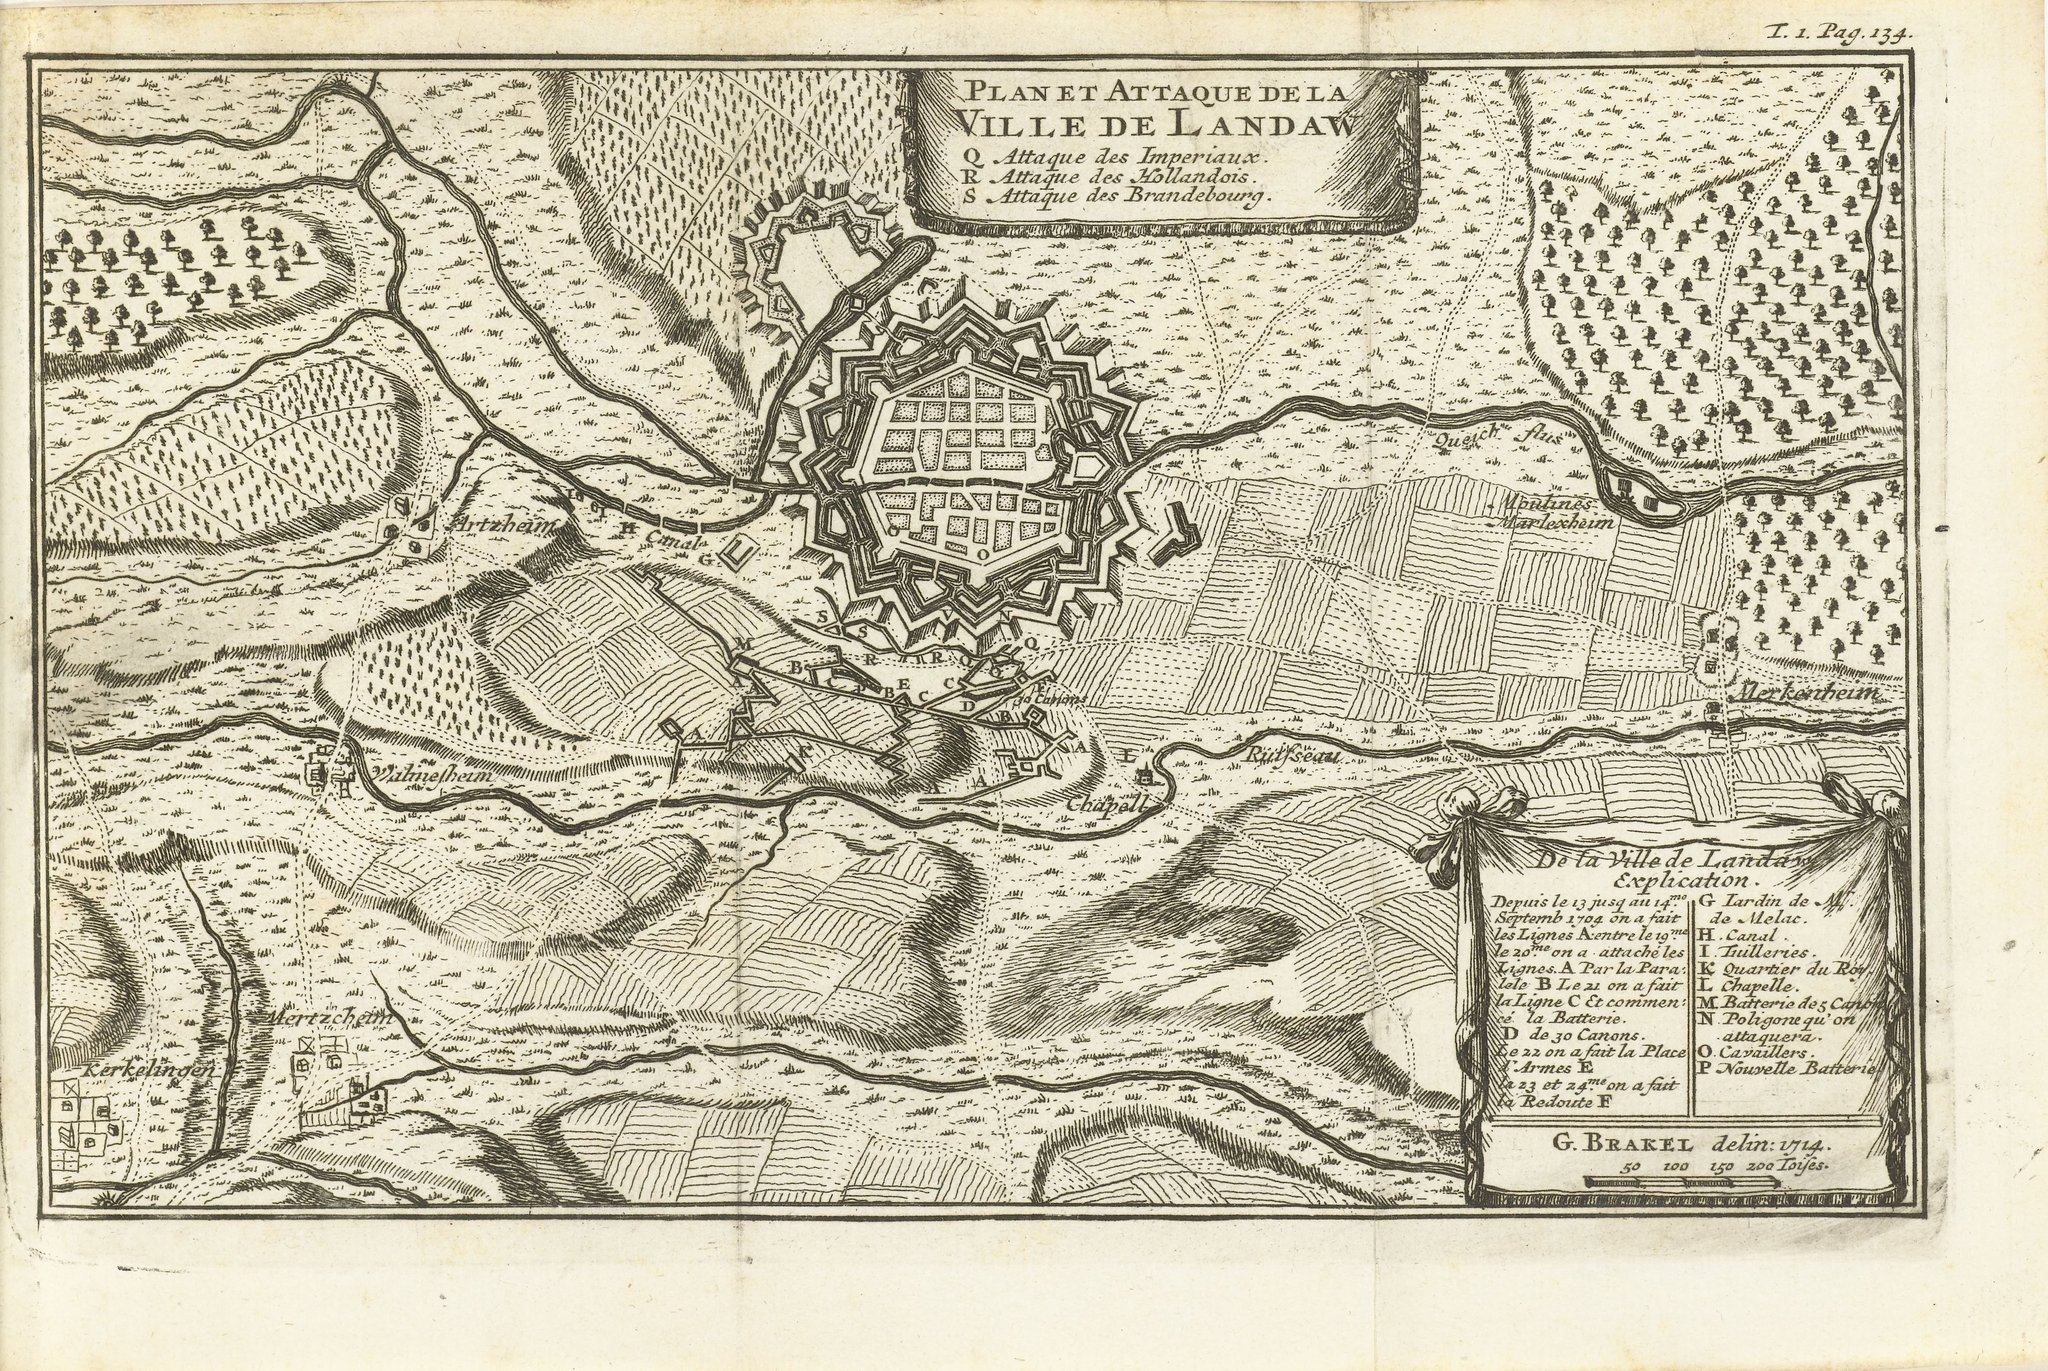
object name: map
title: Beleg van Landau, 1702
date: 1714-1716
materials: paper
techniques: etching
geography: northern netherlands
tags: johan willem friso (prins van oranje-nassau), siege, position war, maps of cities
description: Kaart met het beleg van Landau, veroverd op de Fransen door keizerlijke troepen onder Lodewijk Willem I, markgraaf van Baden-Baden, 10 september 1702. Illustratie in de Nederlandse vertaling uit 1716 van J. Lamigue, Het leven van Zyne Hoogheit Johan Willem Friso, dl. I, p. 134/135.